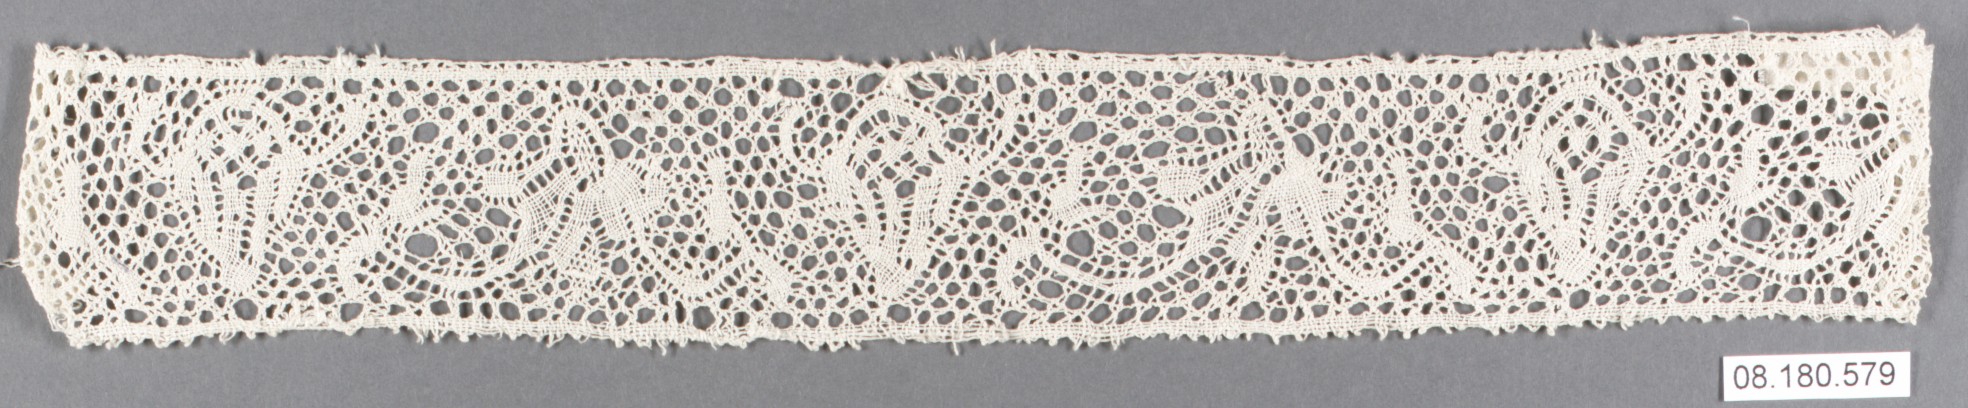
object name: piece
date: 1801-1833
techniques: lace